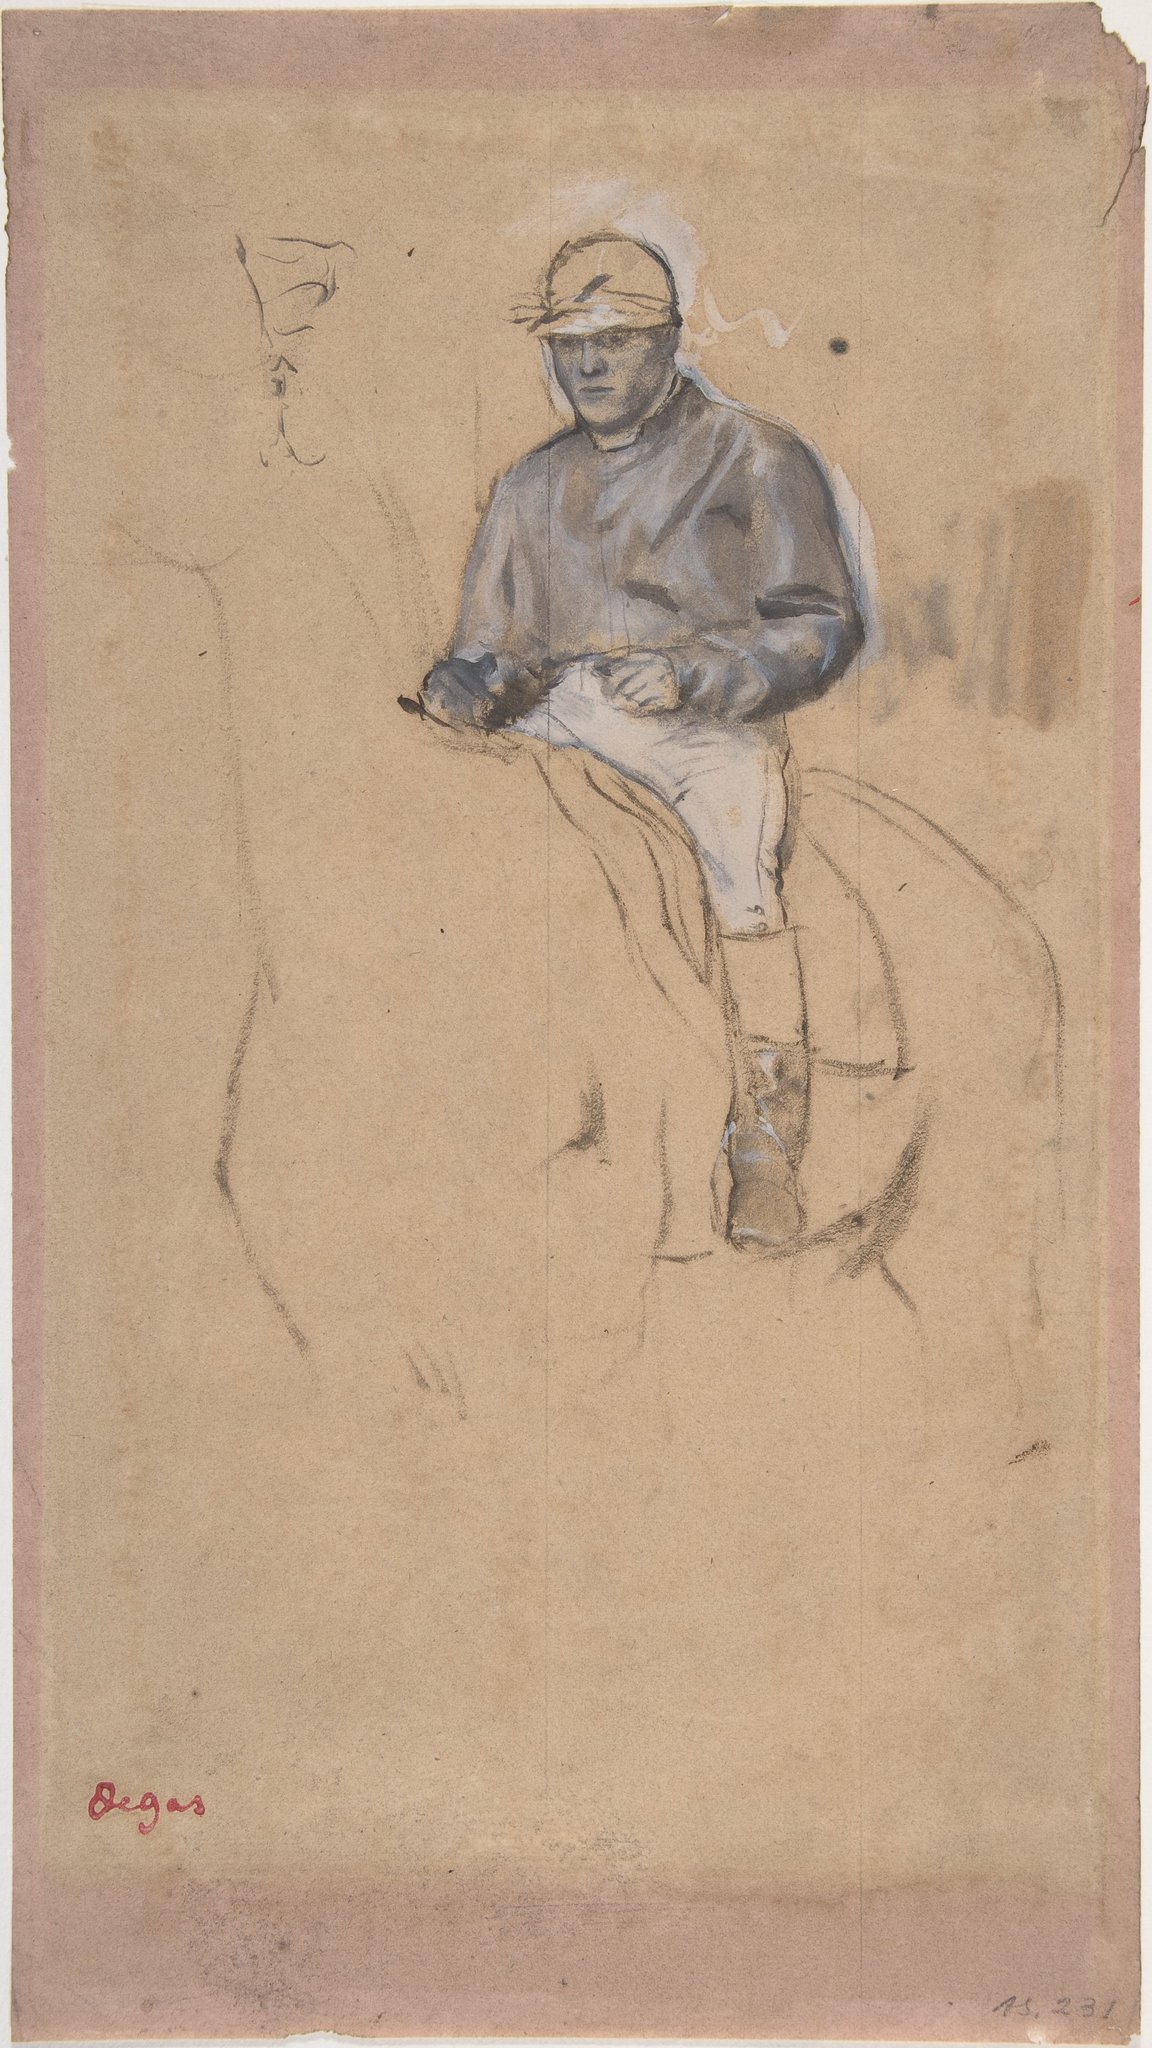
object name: drawing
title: A Jockey on His Horse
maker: edgar degas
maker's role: artist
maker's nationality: french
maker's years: 1834-1917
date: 1868-1870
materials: graphite, oil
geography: france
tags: men,horses,jockeys